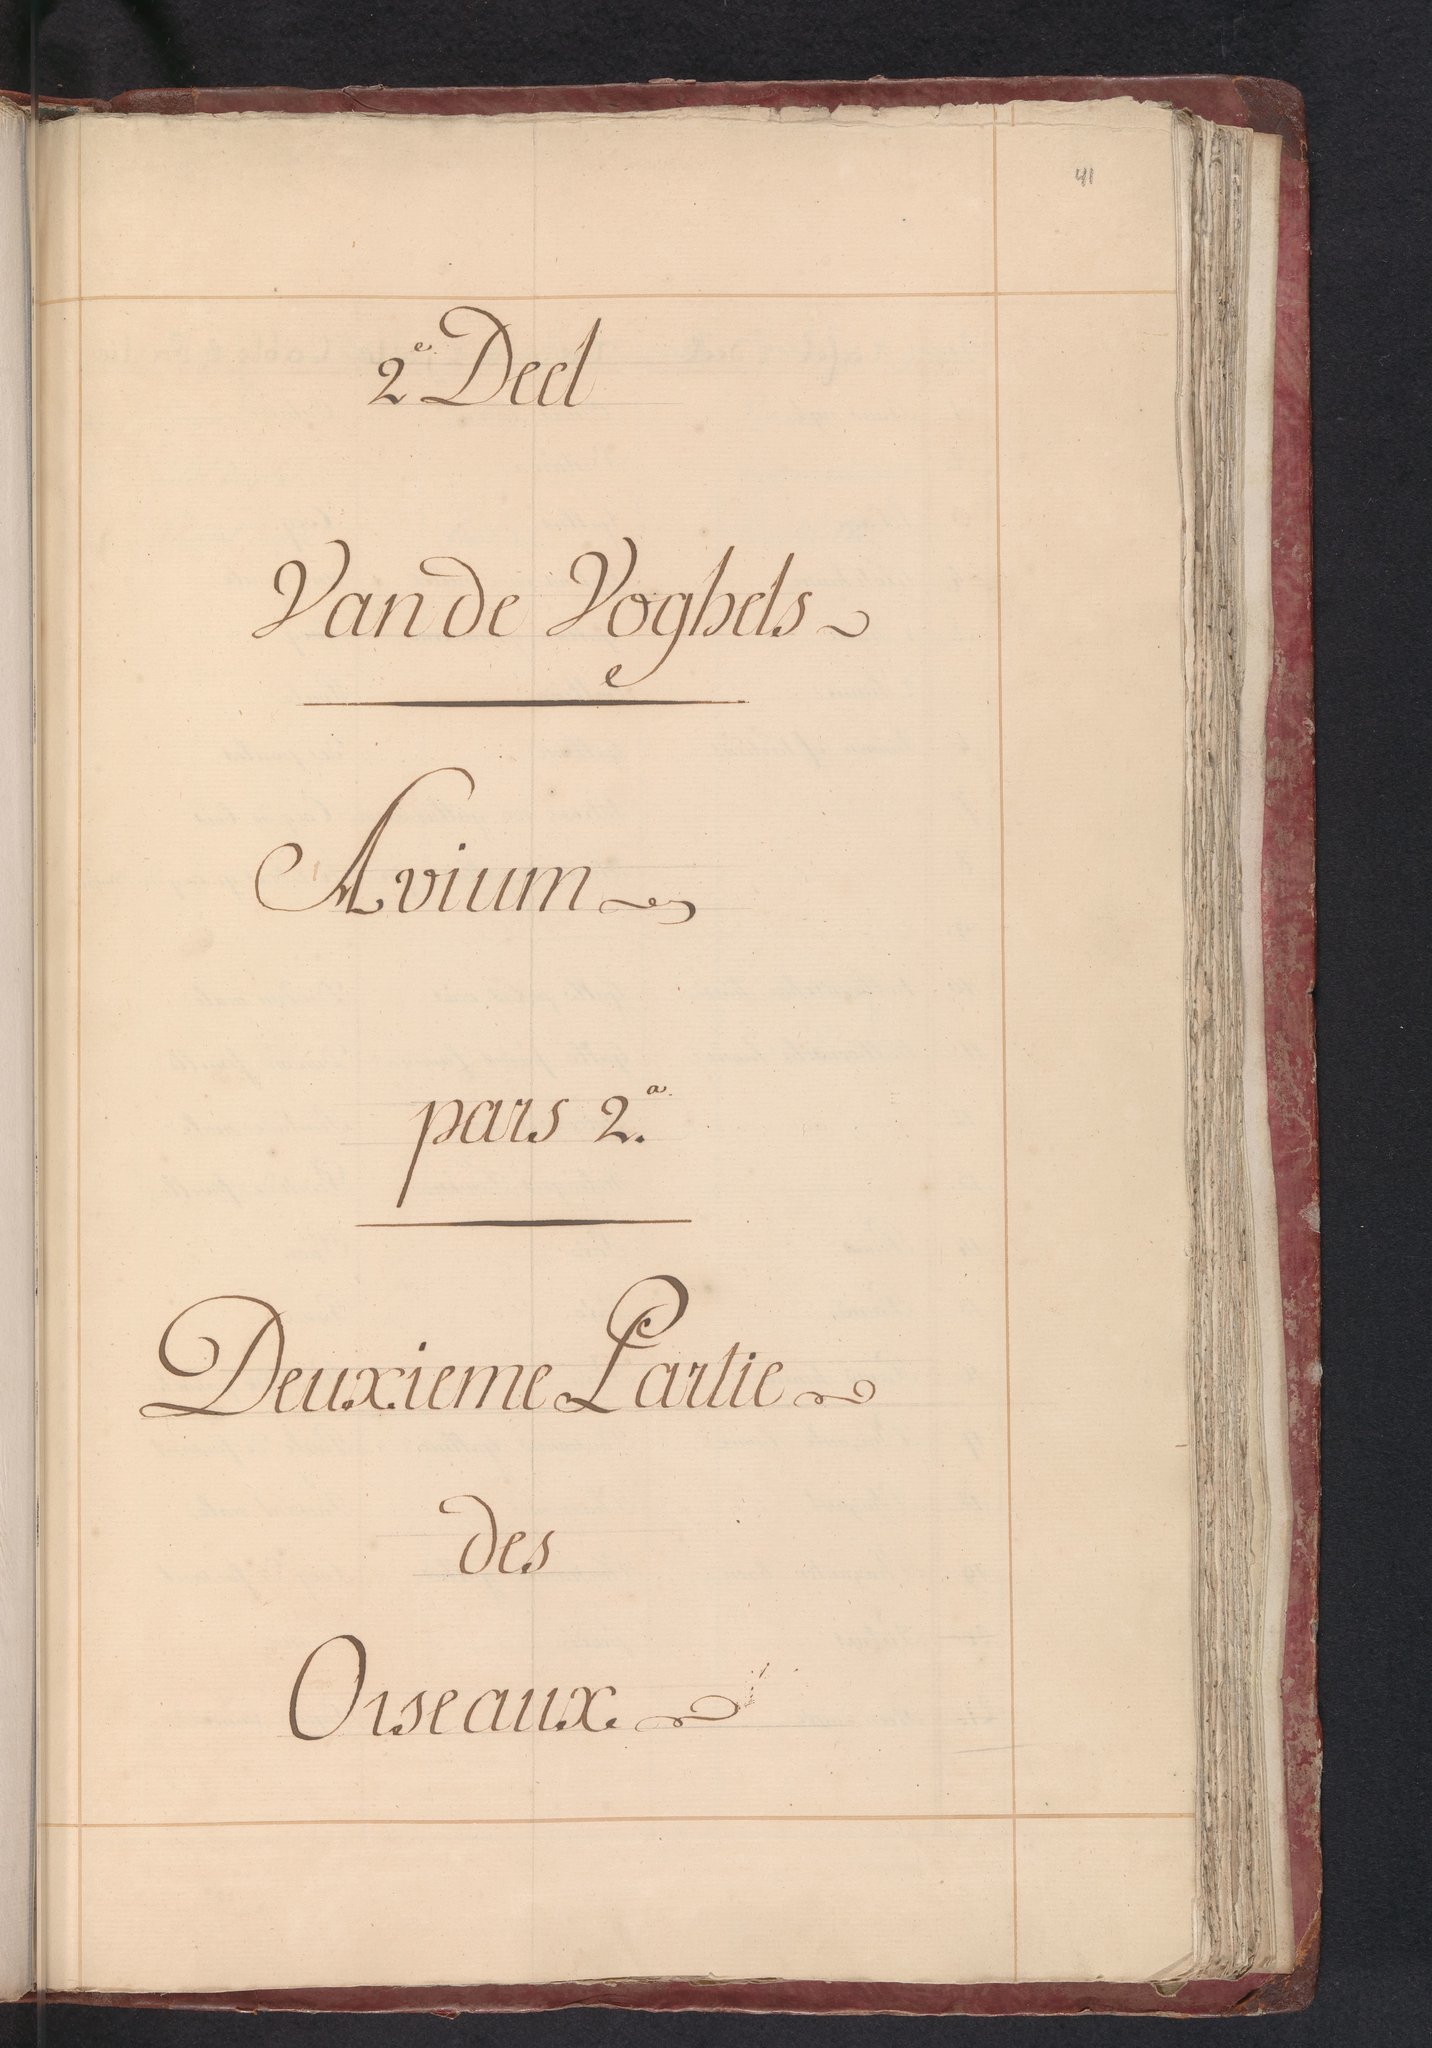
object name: manuscript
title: 2e Deel Van de Voghels / Avium pars 2a. / Deuxieme Partie des Oiseaux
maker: joseph van huerne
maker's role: kunstliefhebber, mecenas, verzamelaar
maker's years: 1752-1844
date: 1809-1814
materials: ink, paper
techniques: handwriting, pen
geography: bruges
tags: handwriting, written text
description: Handgeschreven titelpagina voor het tweede deel van de voorstellingen van vogels. Onderdeel van het eerste album met tekeningen van vogels. Derde van twaalf albums met tekeningen van dieren, vogels en planten bekend rond 1600, gemaakt in opdracht van keizer Rudolf II. Met toelichting in Nederlands, Latijn en Frans.